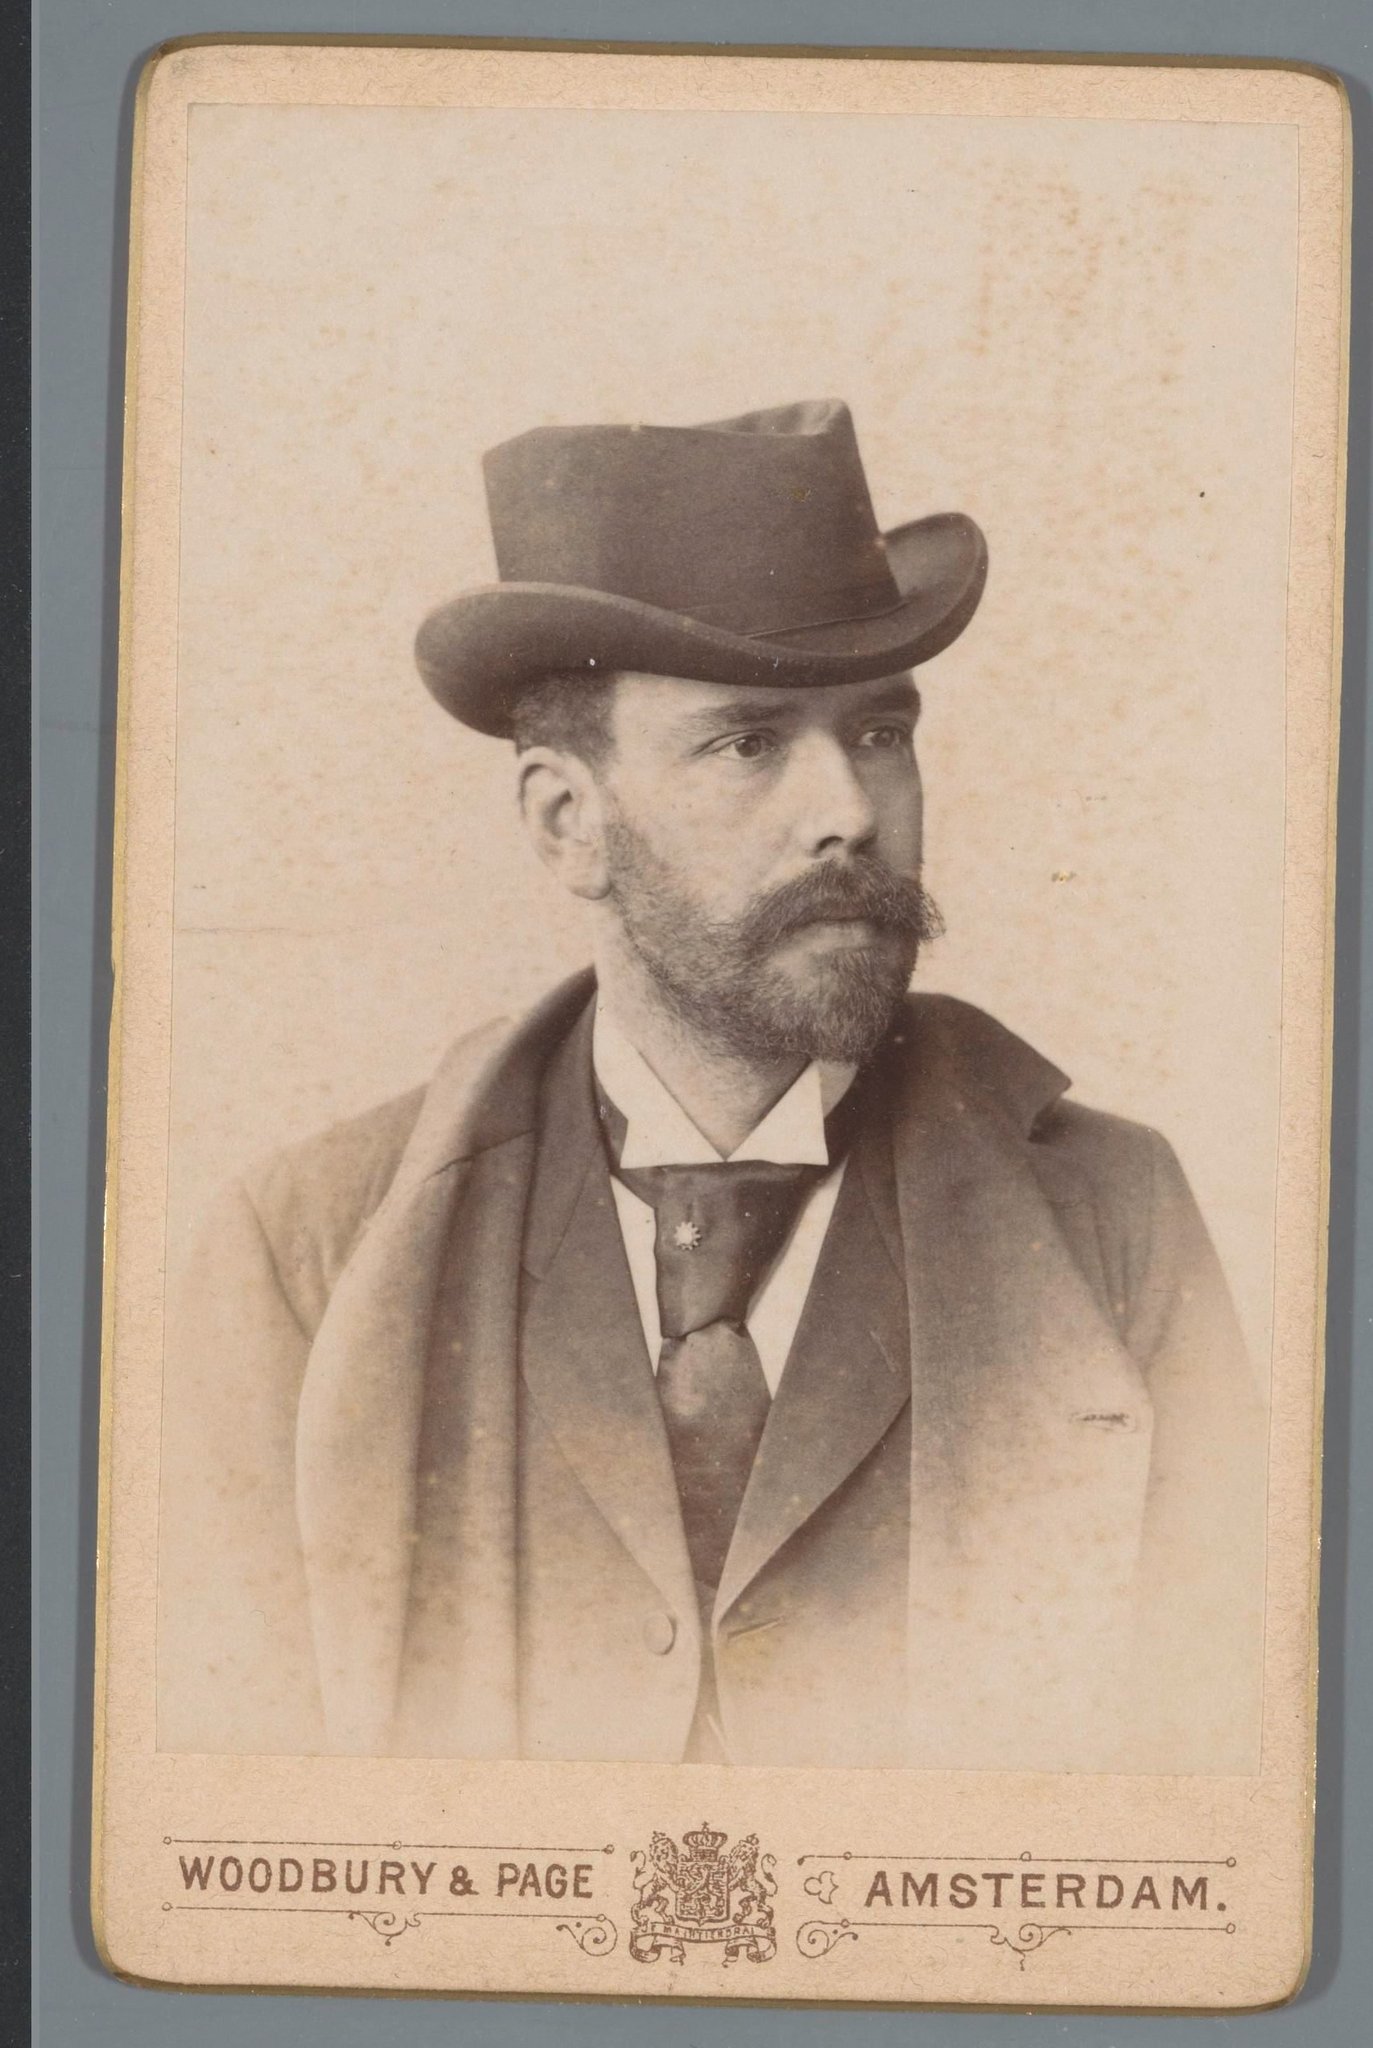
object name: photograph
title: Portret van een onbekende man met hoed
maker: felix friedrich busenbender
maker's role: fotograaf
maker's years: 1860-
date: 1888-1892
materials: cardboard, paper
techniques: albumen print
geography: amsterdam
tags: adult man, anonymous historical person portrayed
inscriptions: address: ‘Amsterdam/ DAMSTRAAT 23/ en/ Batavia.’